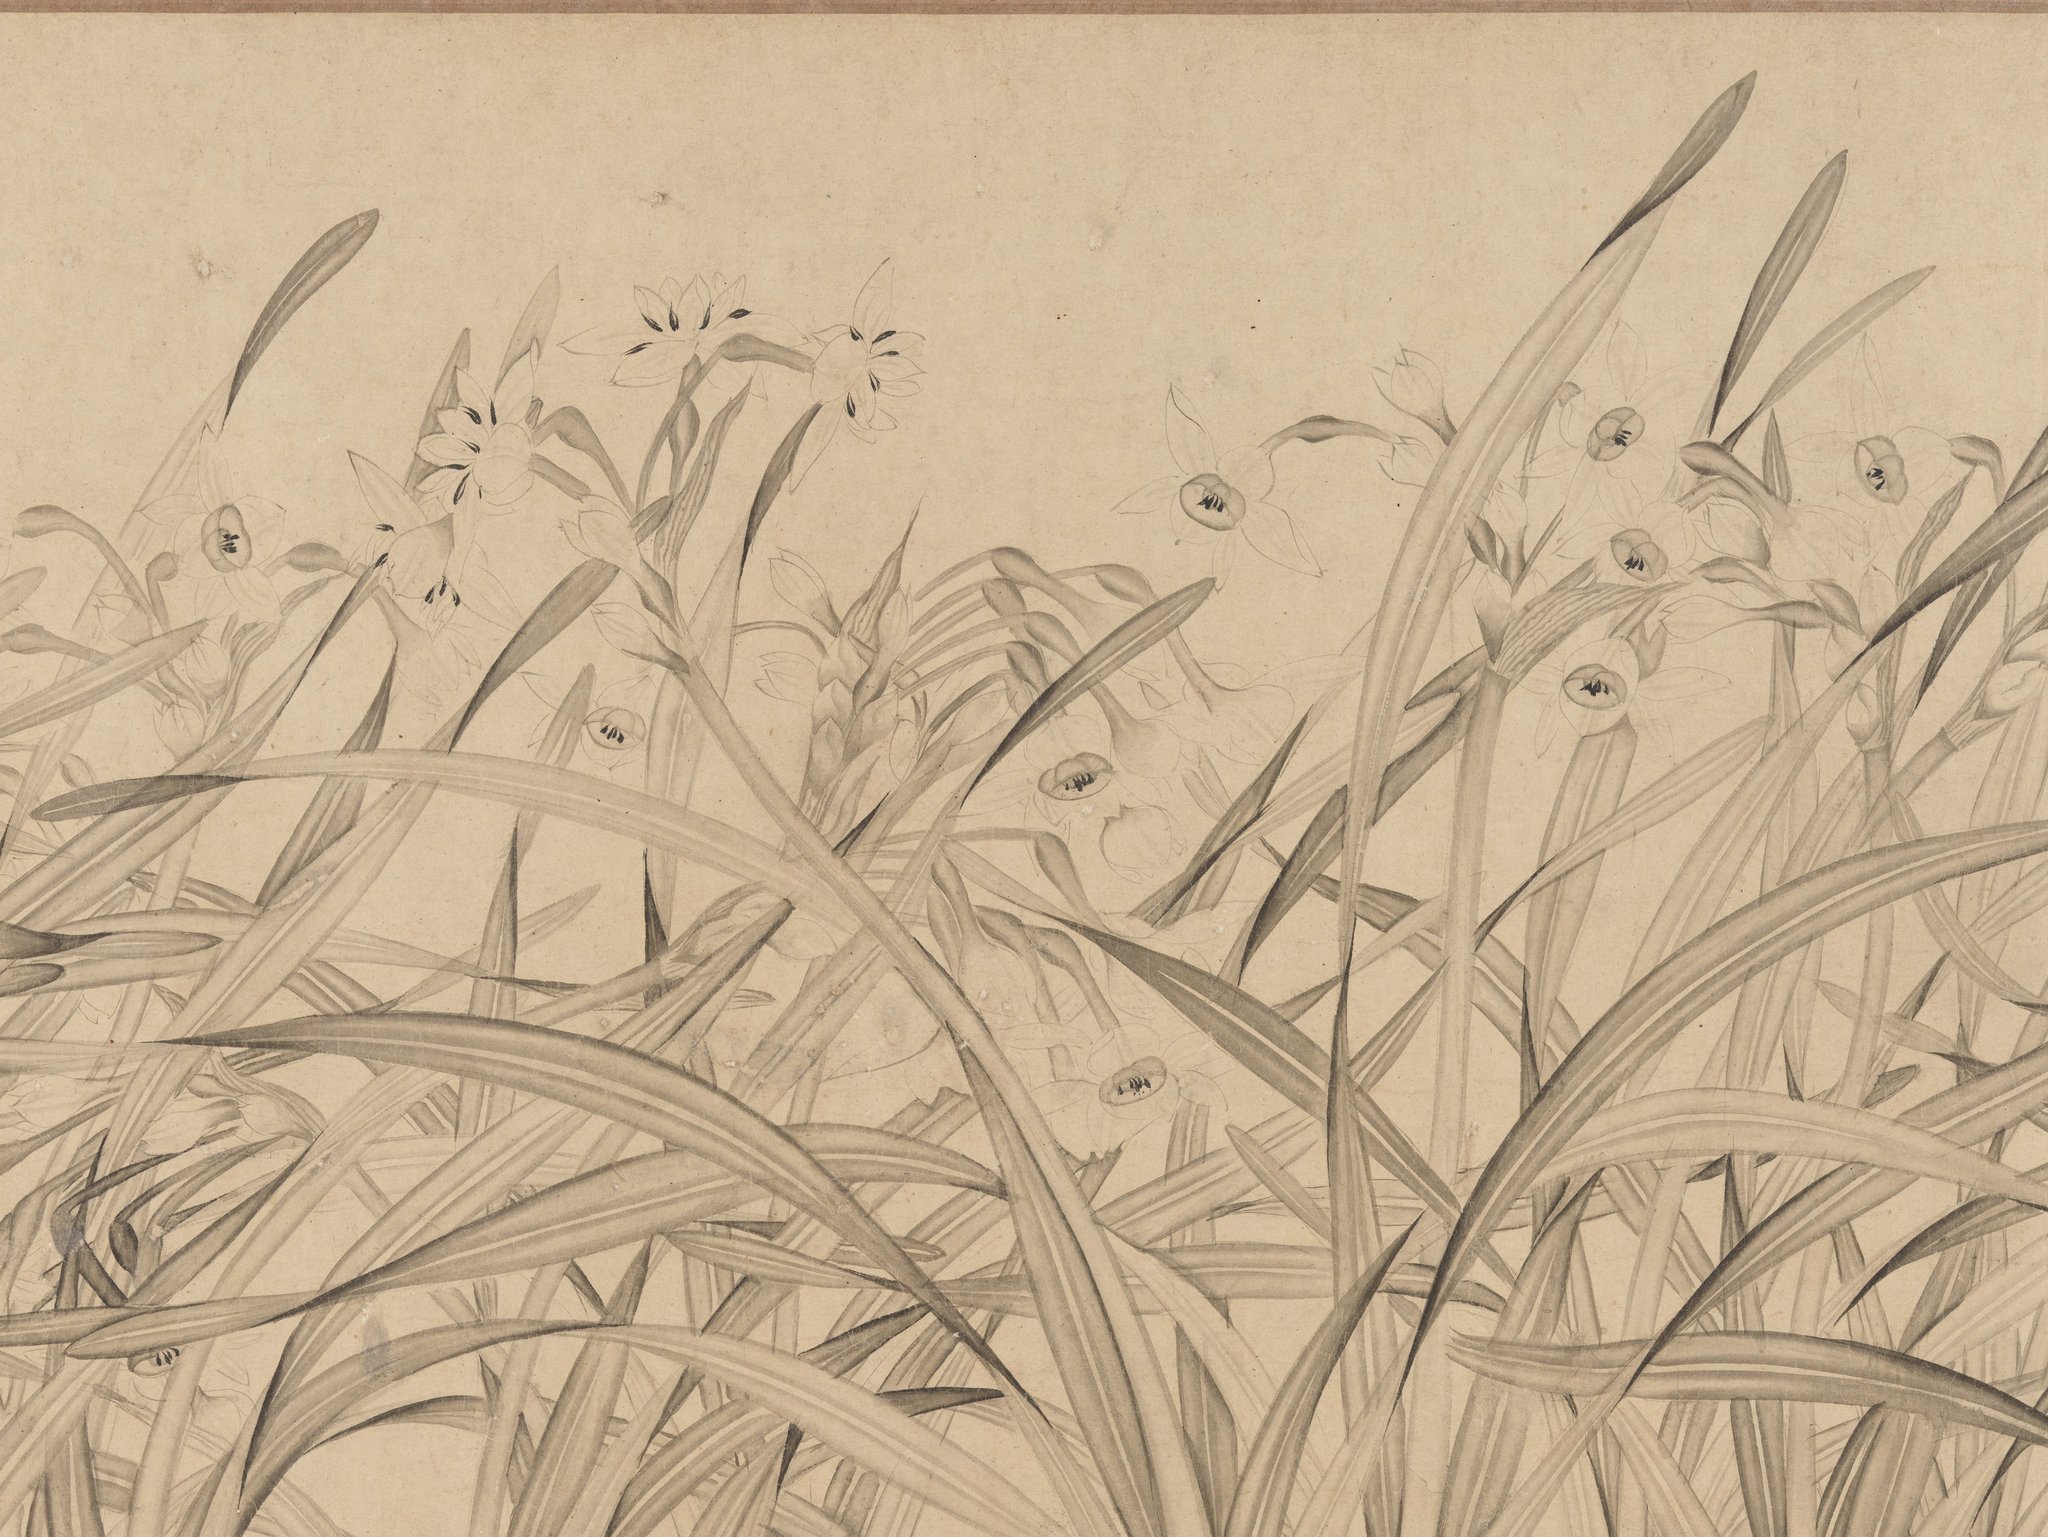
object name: handscroll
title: Narcissus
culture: chinese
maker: zhao mengjian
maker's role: artist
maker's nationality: chinese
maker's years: 1199-1267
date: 1234-1266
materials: ink, paper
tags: narcissus,plants